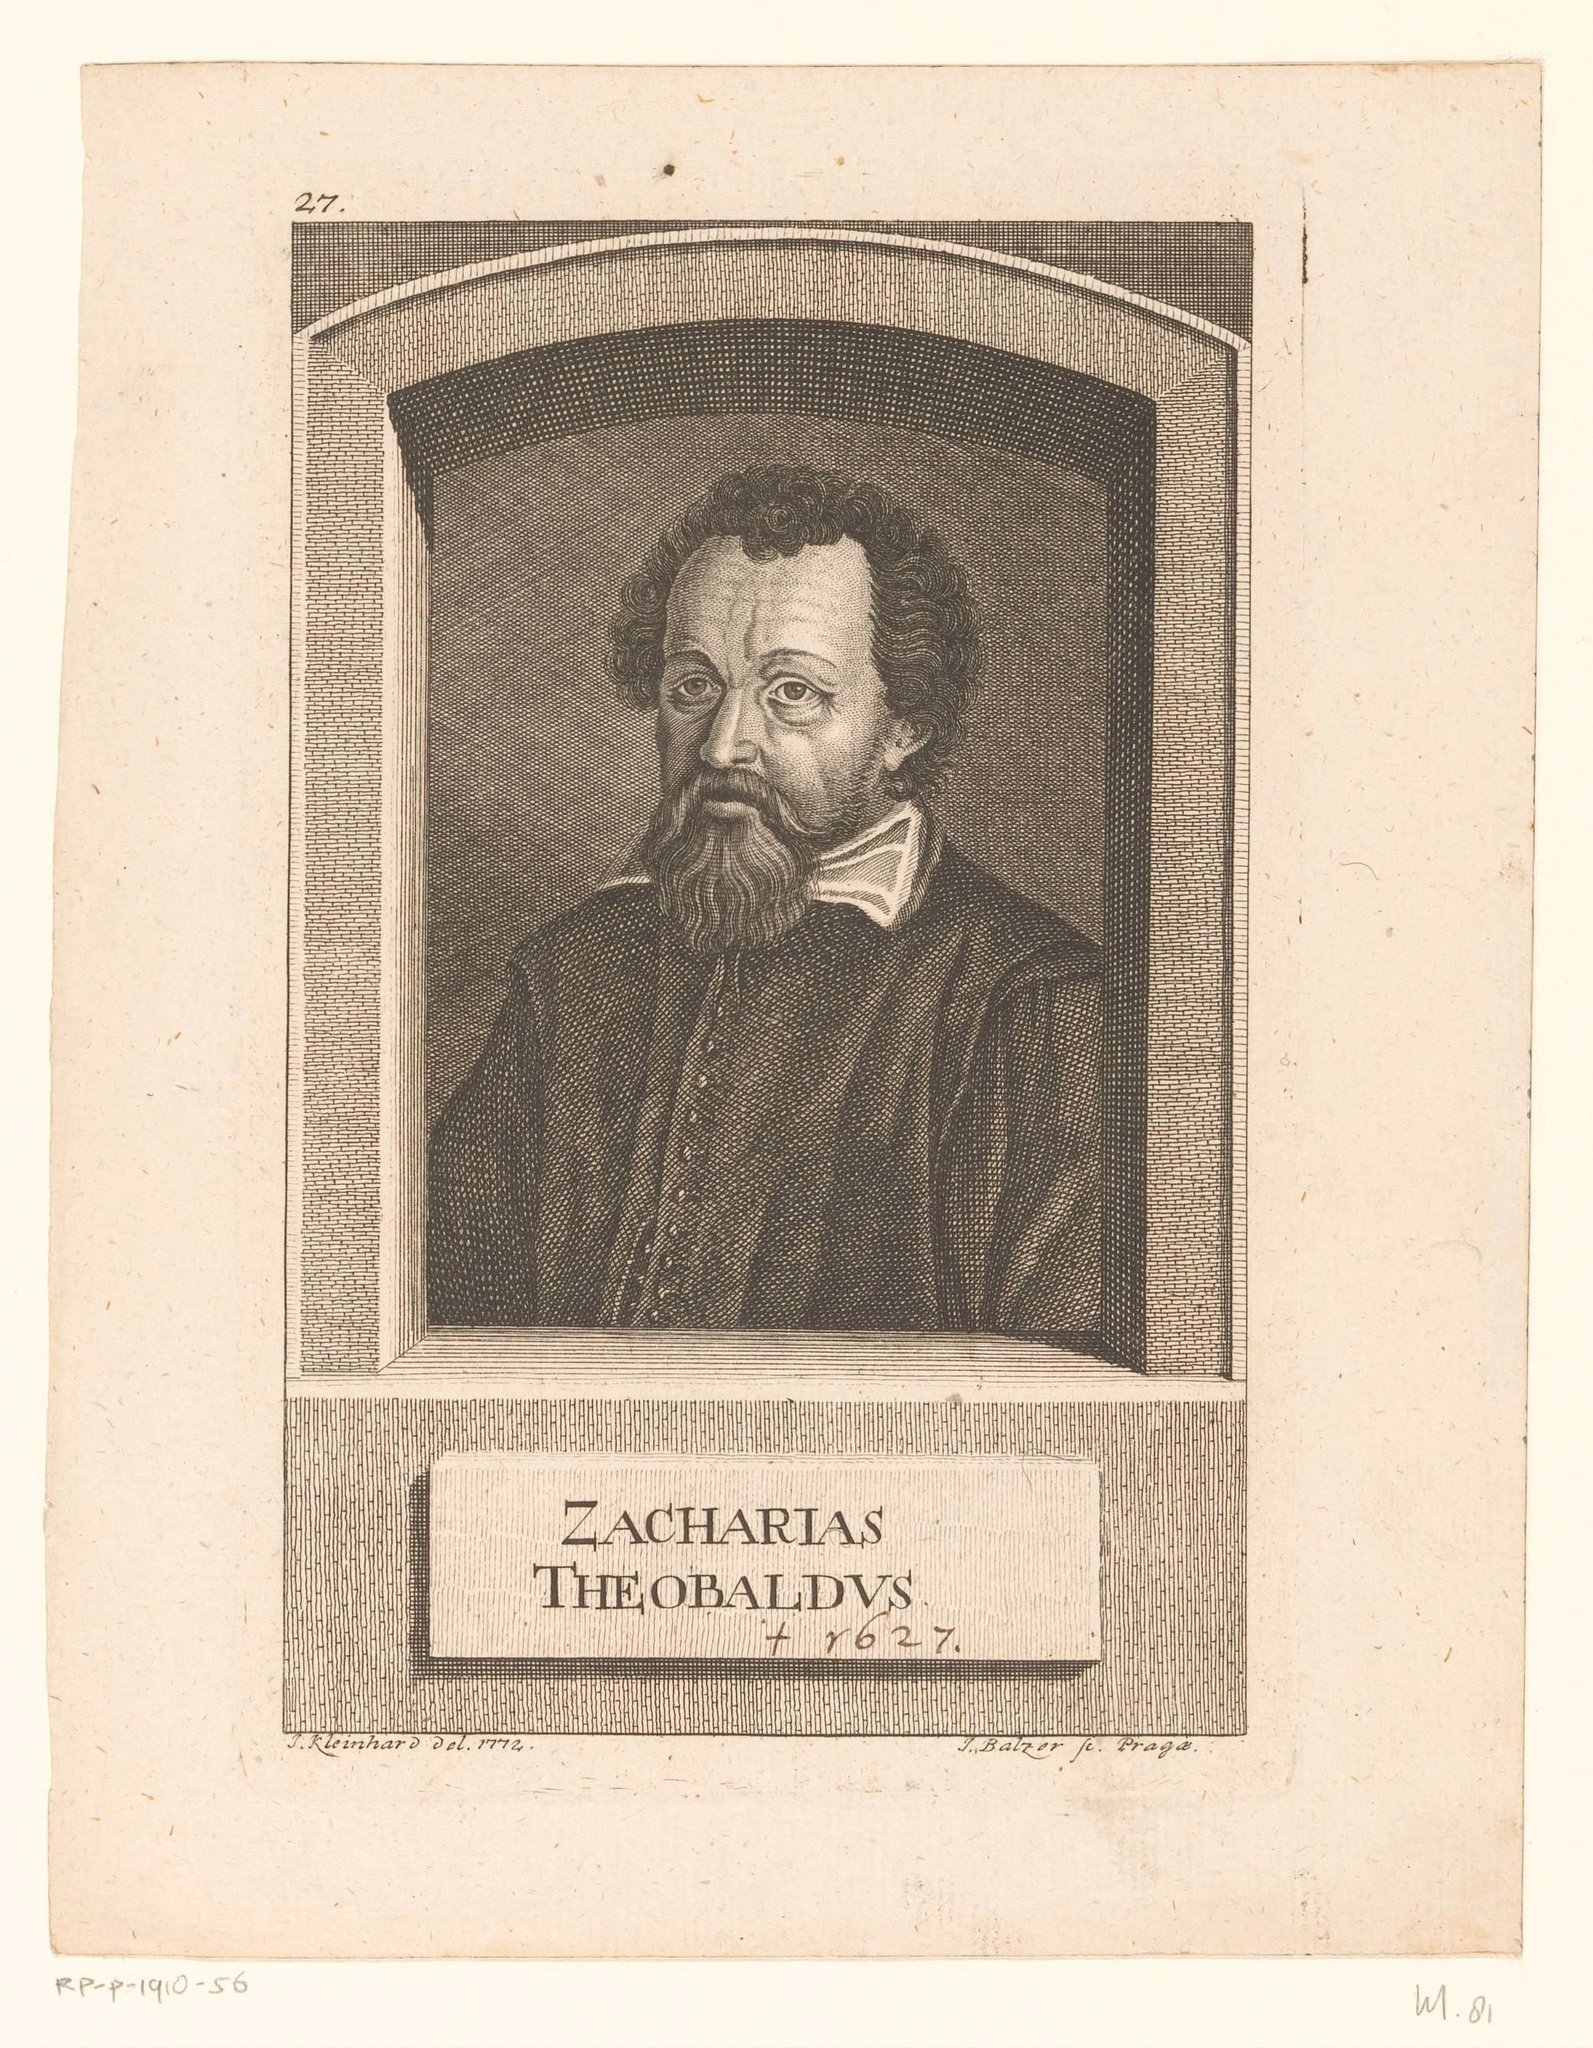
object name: print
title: Zacharias Theobaldus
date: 1772-1799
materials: paper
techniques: engraving, etching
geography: prague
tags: historical persons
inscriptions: inscription: ‘1627’, collector's mark: Lugt 2228